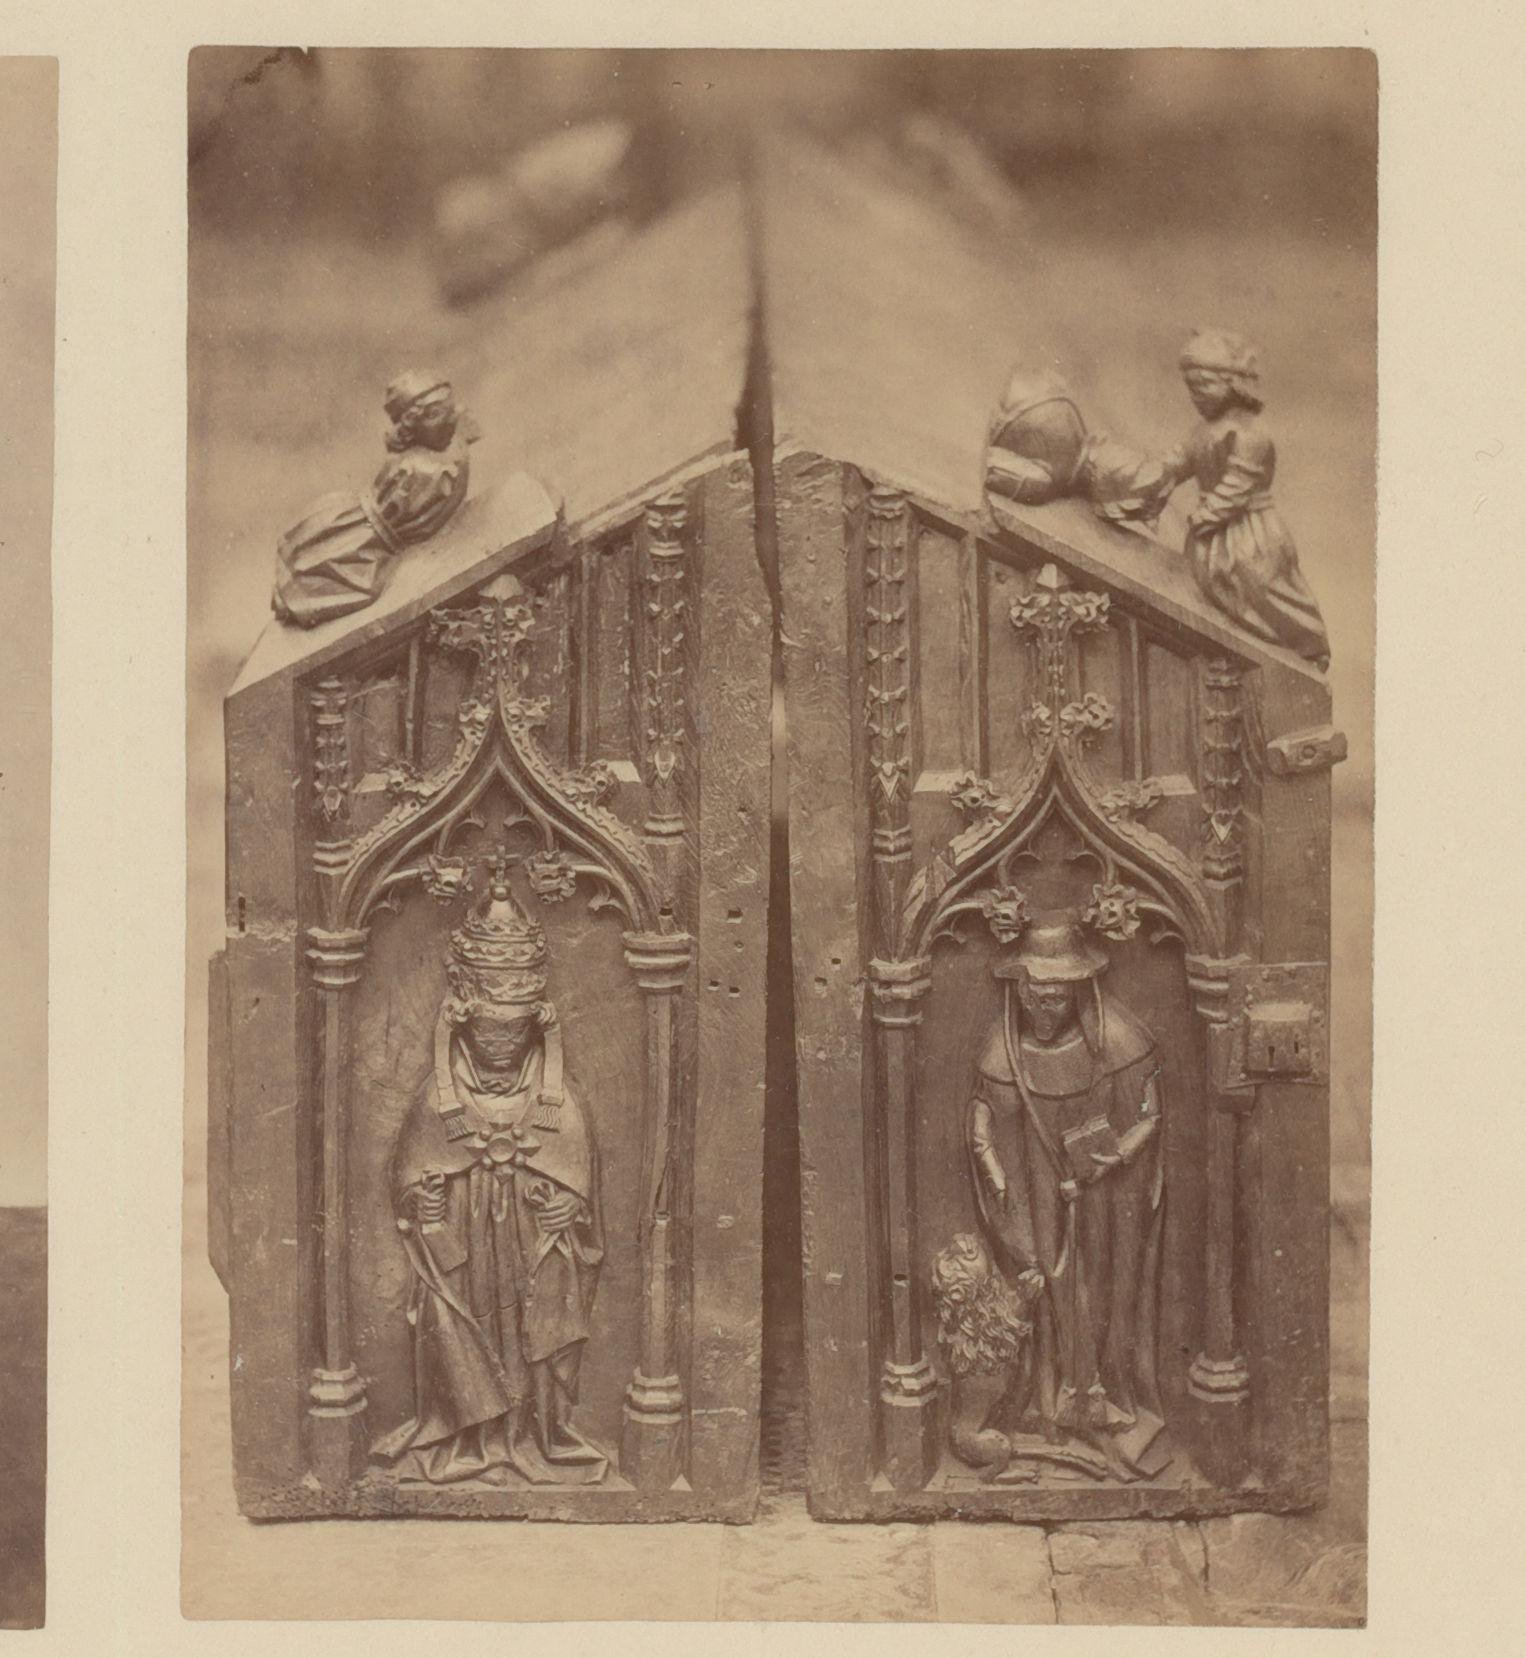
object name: photograph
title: Foto's van houtsnijwerk in de Martinikerk te Bolsward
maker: g.m. märckelbach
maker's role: publisher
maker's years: 1853-1904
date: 1879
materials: photographic support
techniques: albumen print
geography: bolsward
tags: carving ~ applied arts, piece of sculpture, reproduction of a piece of sculpture, wood carver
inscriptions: collector's mark: Lugt 1641, collector's mark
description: In een advertentie wordt de fotoserie aangeboden: HH. Liefhebbers van Antiquiteiten. GOTHIEKE BANKEN uit de XVe Eeuw. St. MARTINIKERK.--BOLSWARD. 8 Photographieën à f 4.50. ANTIEKE PREEKSTOEL, uit het midden der XVIIe EEUW. 4 Photographieën à f 2.25. Uitgave van: GEBRs. CORDES, Photografen [and] G.M. MÄRCKELBACH, Boek- en Kunsthandel, BOLSWARD. (Het nieuws van den dag: kleine courant, 12-07-1879.)